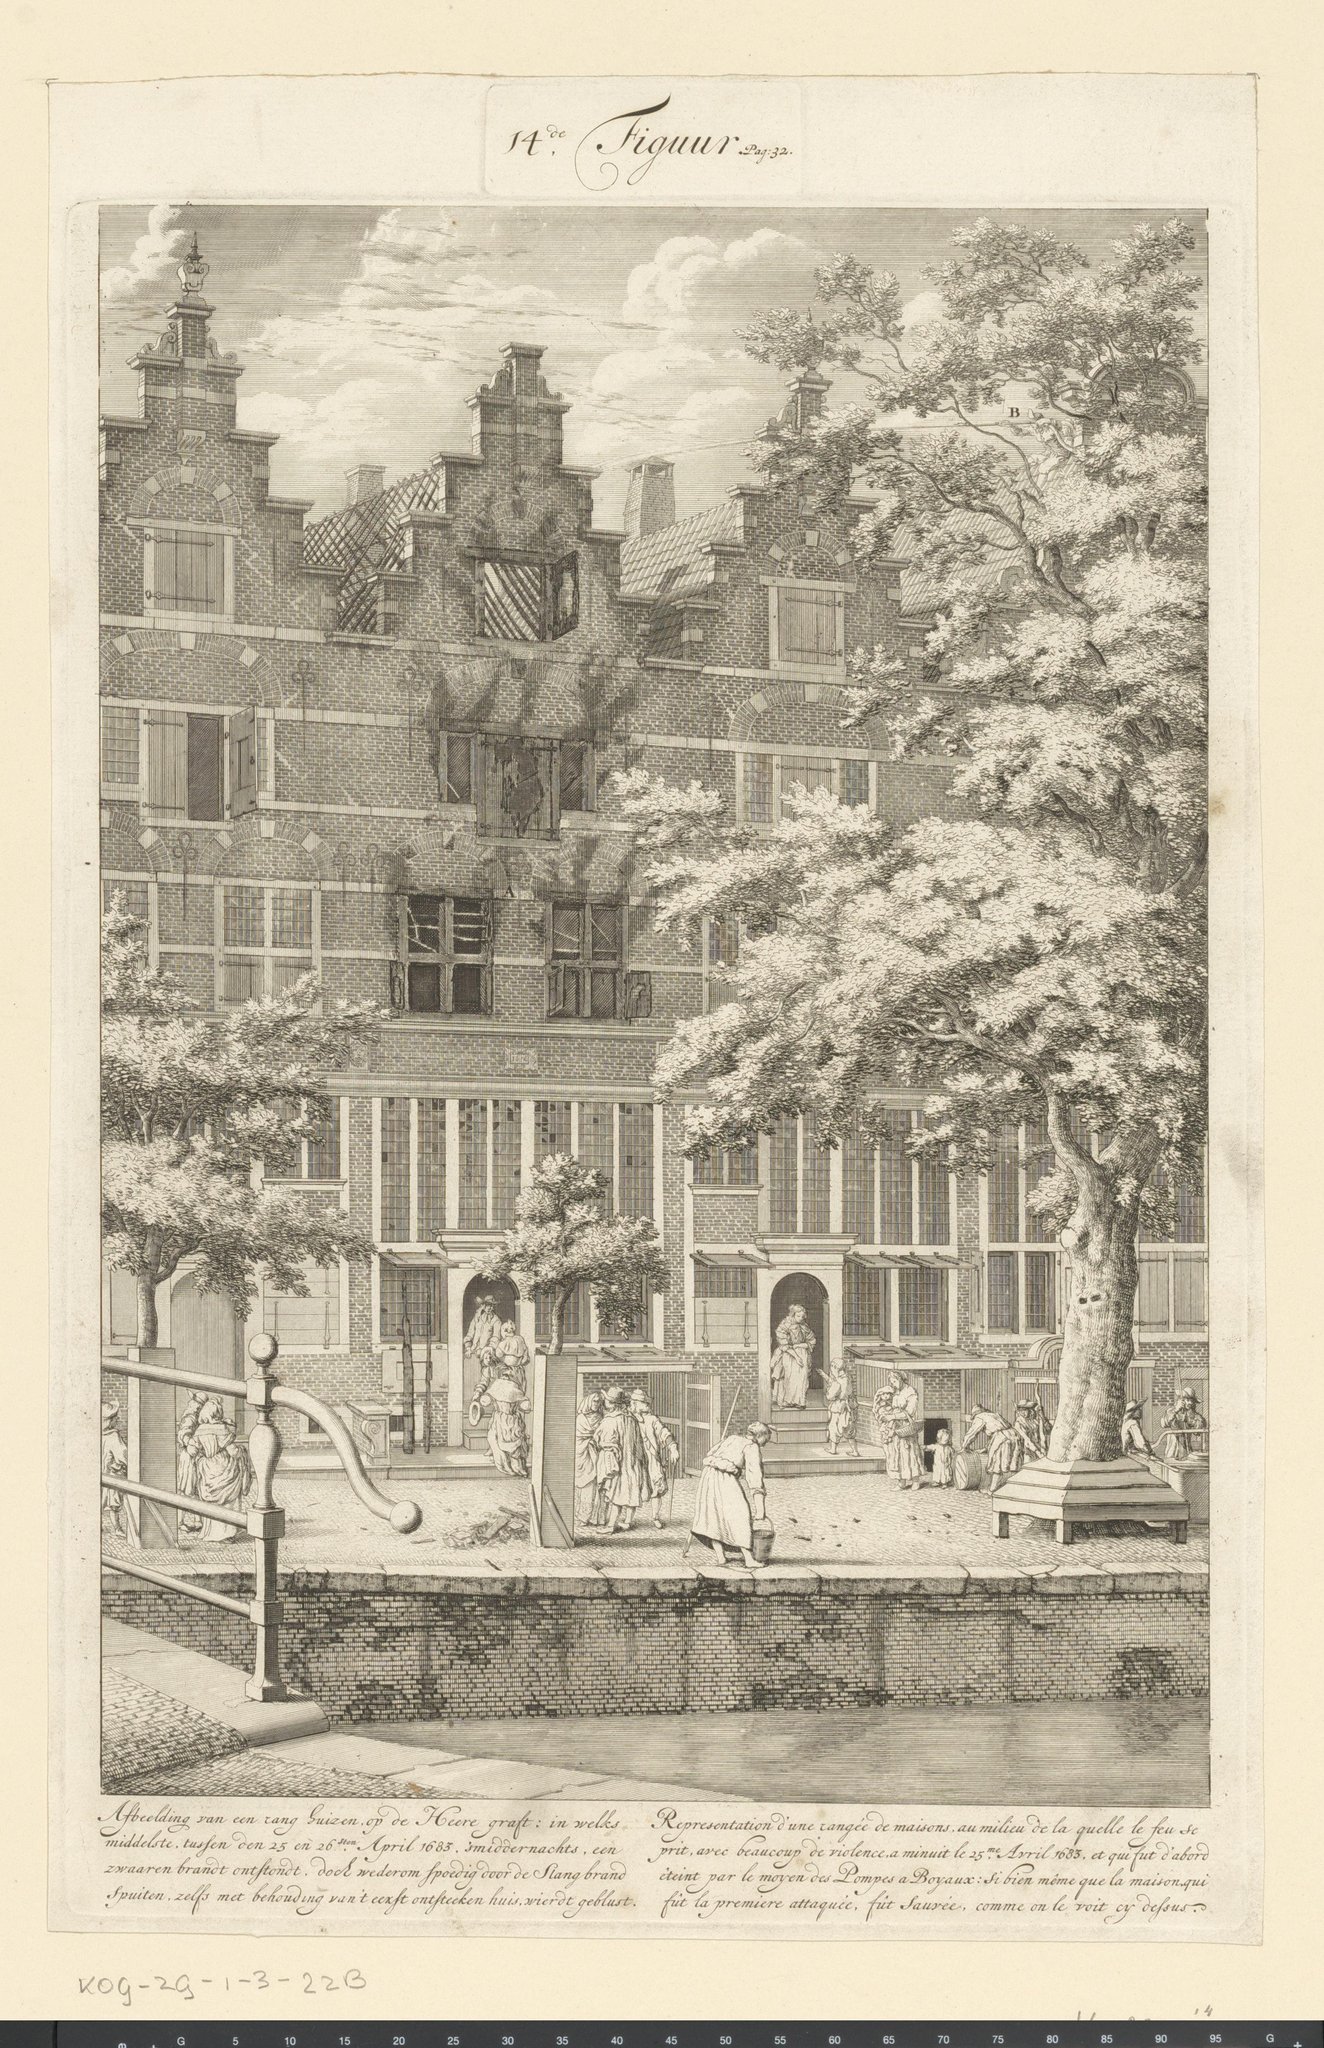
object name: print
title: Uitgebrand huis op de Herengracht, 1683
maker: jan van der heyden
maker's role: draughtsman, painter, print maker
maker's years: 1637-1712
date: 1735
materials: paper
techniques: engraving, etching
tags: urban housing, on fire, ablaze, ruin of a building ~ architecture, canals, waters (in city)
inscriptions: stamp, collector's mark: Lugt 1641, stamp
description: Een huis op de Herengracht te Amsterdam waar in de nacht van 25 op 26 april 1683 brand heeft gewoed, maar dat door tijdig blussen met slangbrandspuiten behouden is gebleven. Links ligt de brug voor de Hartenstraat. Met vierregelig onderschrift in het Nederlands en Frans. Bovenaan de tekst: 14de Figuur Pag: 32. Onderwerpsrubrieken binnen de Atlas Zeden en Gewoonten: Regeering, Brandwezen.